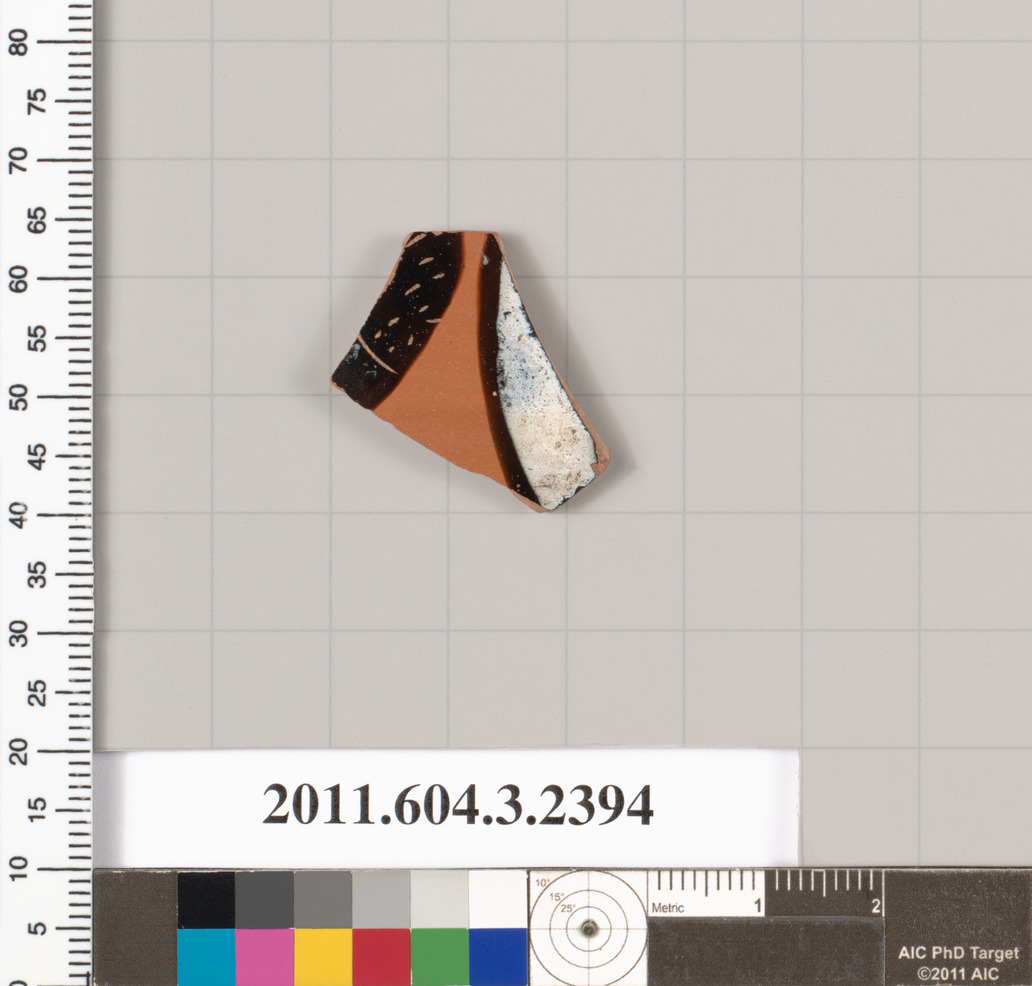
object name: kylix fragment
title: Terracotta fragment of a kylix: eye-cup (drinking cup)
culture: greek, attic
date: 530-510 BCE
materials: terracotta